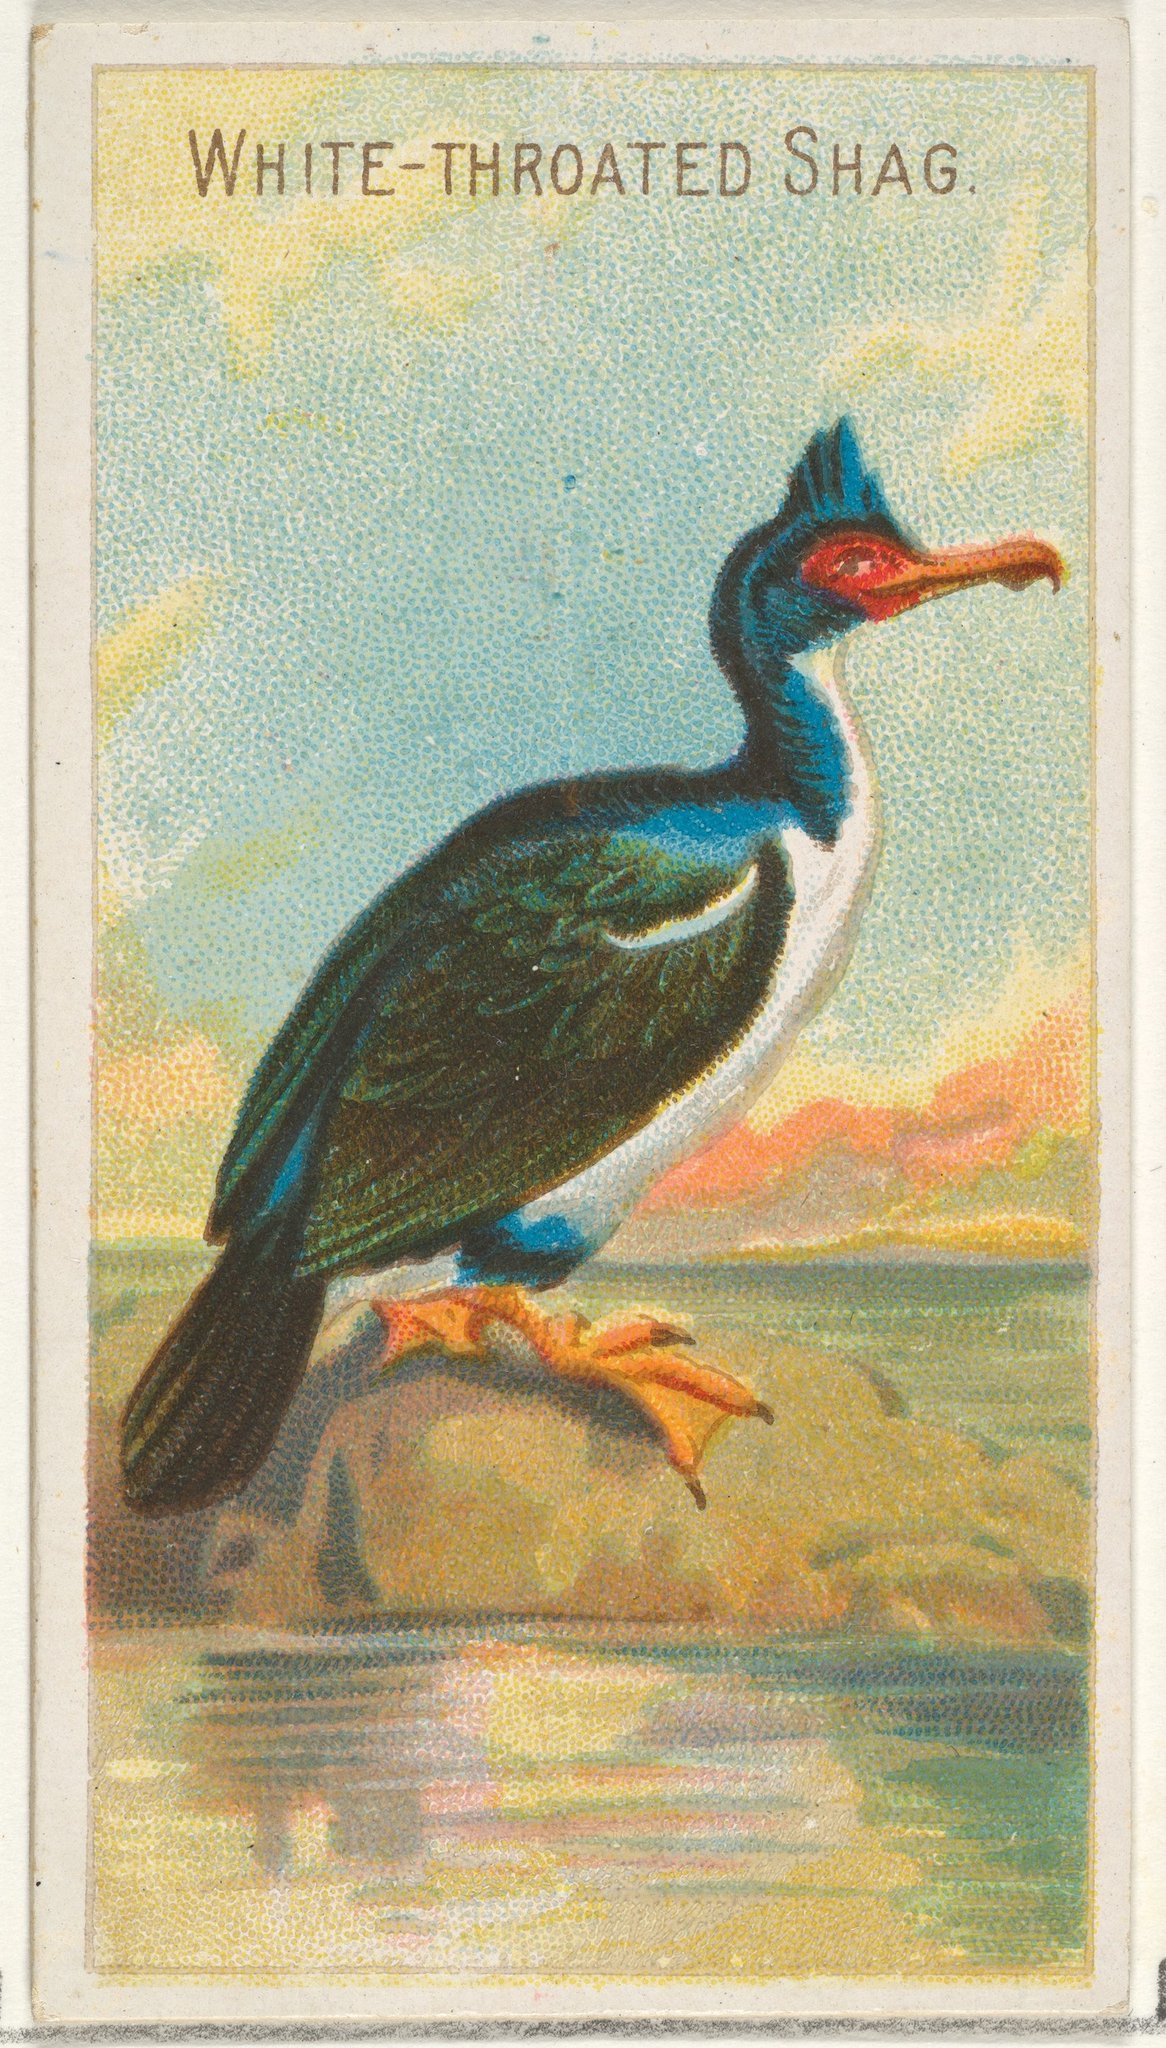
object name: print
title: White-Throated Shag, from the Birds of the Tropics series (N5) for Allen & Ginter Cigarettes Brands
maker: allen & ginter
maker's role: publisher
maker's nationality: american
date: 1889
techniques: color lithograph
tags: birds